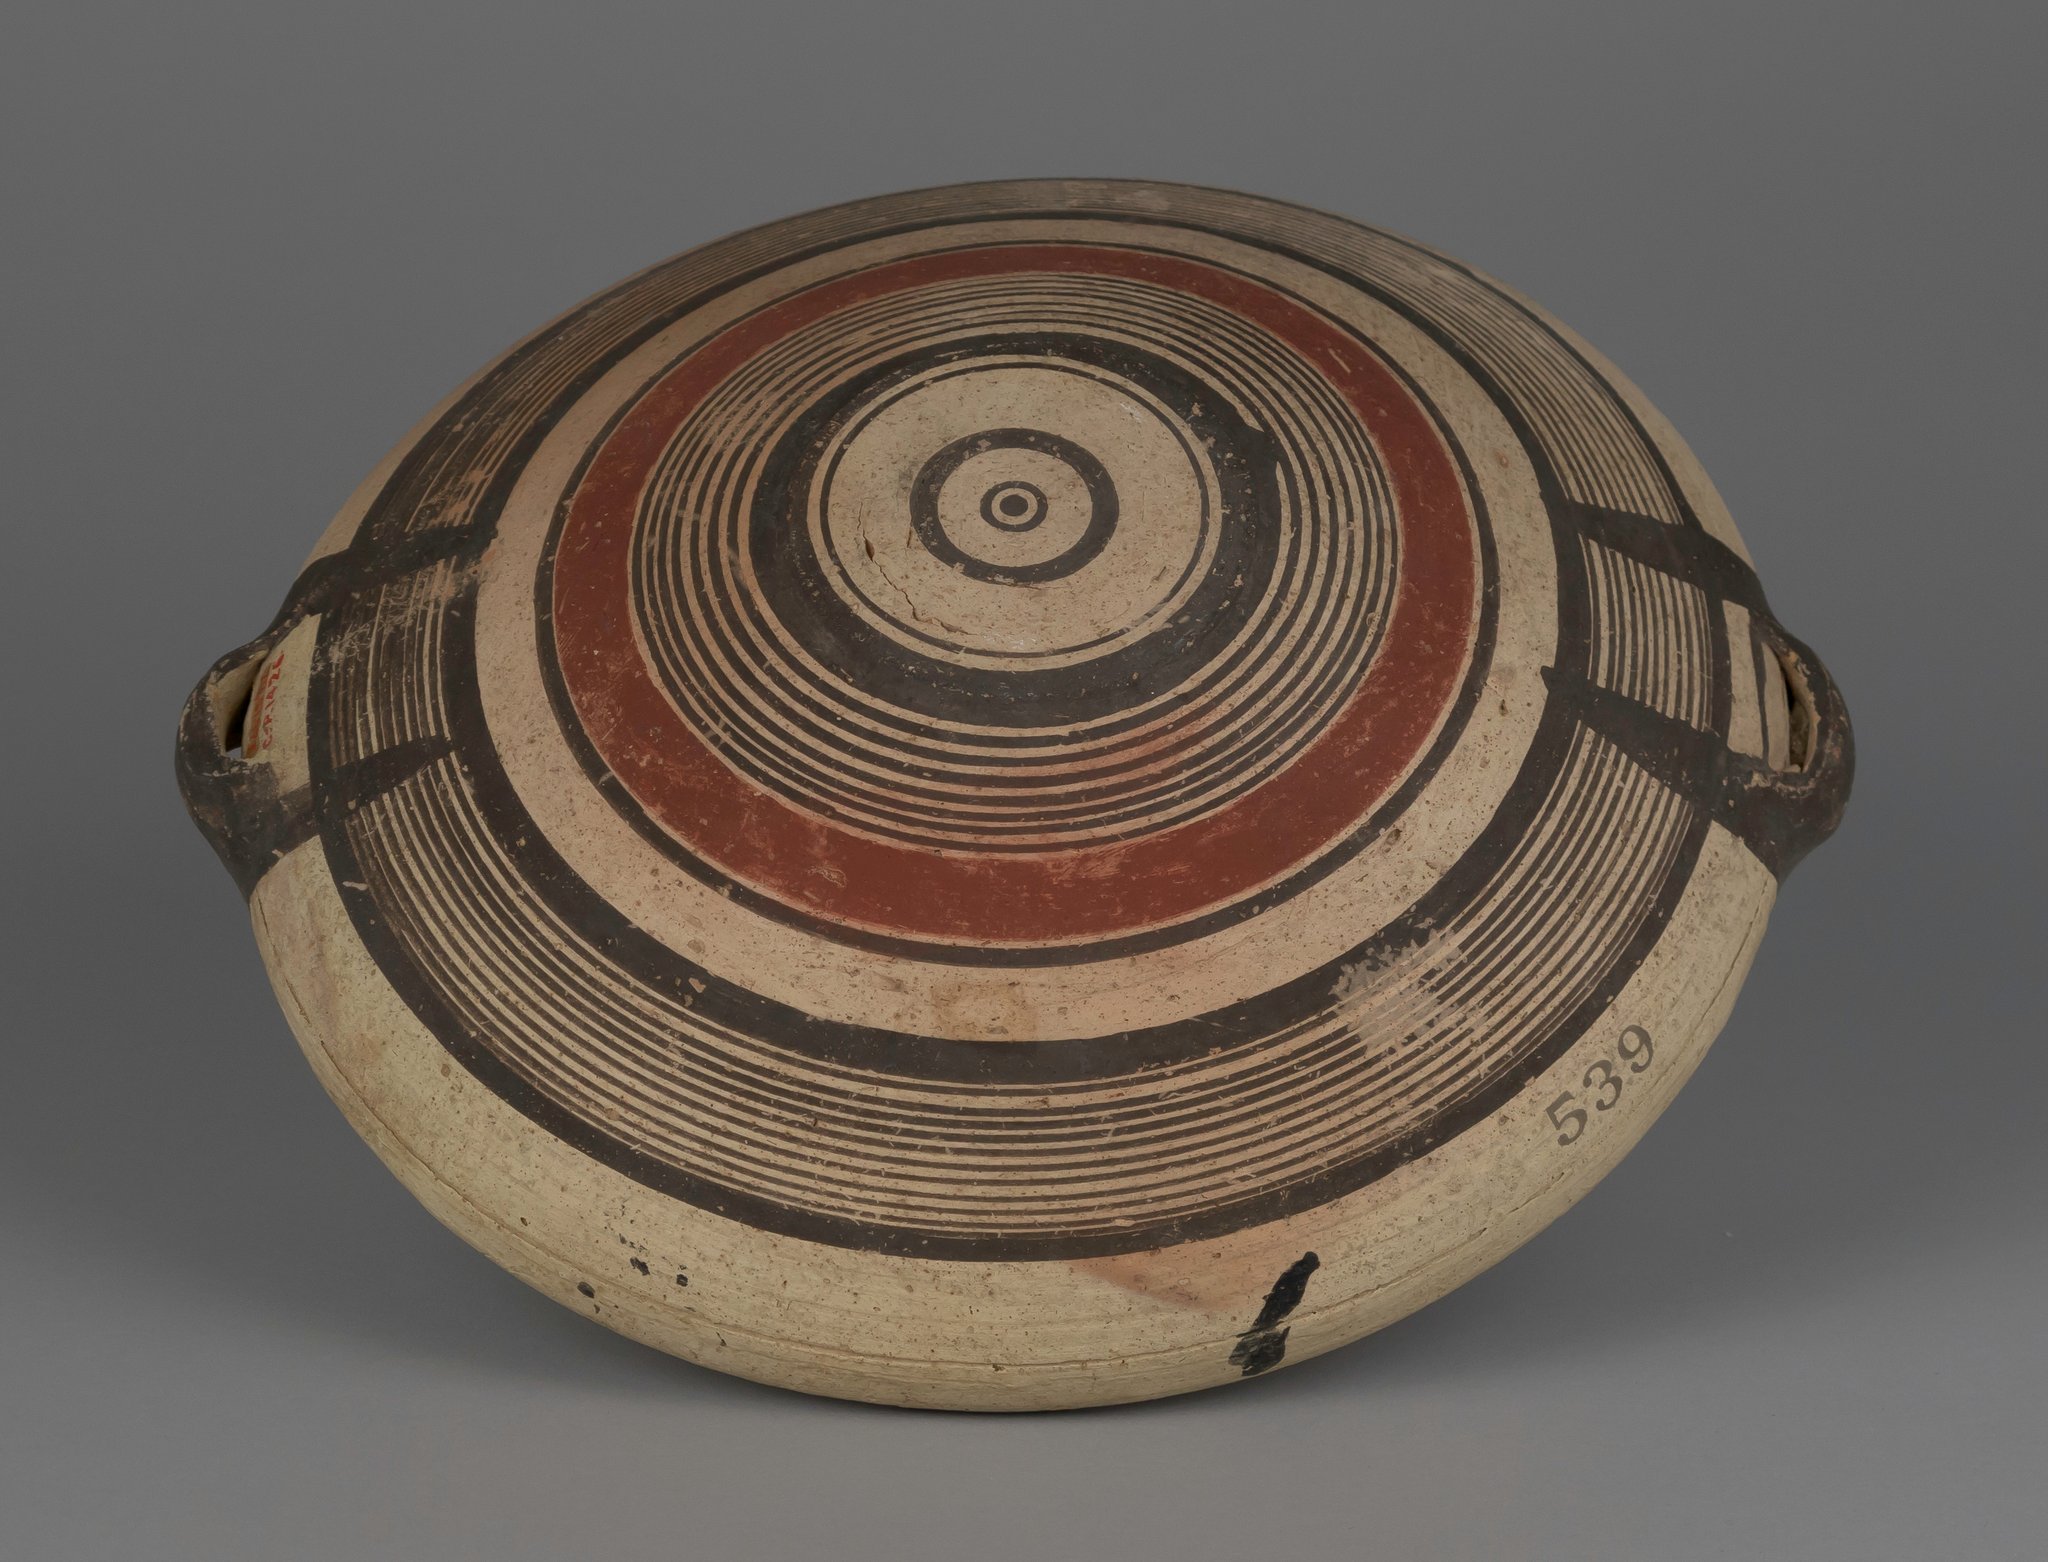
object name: plate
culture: cypriot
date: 750-600 BCE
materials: terracotta